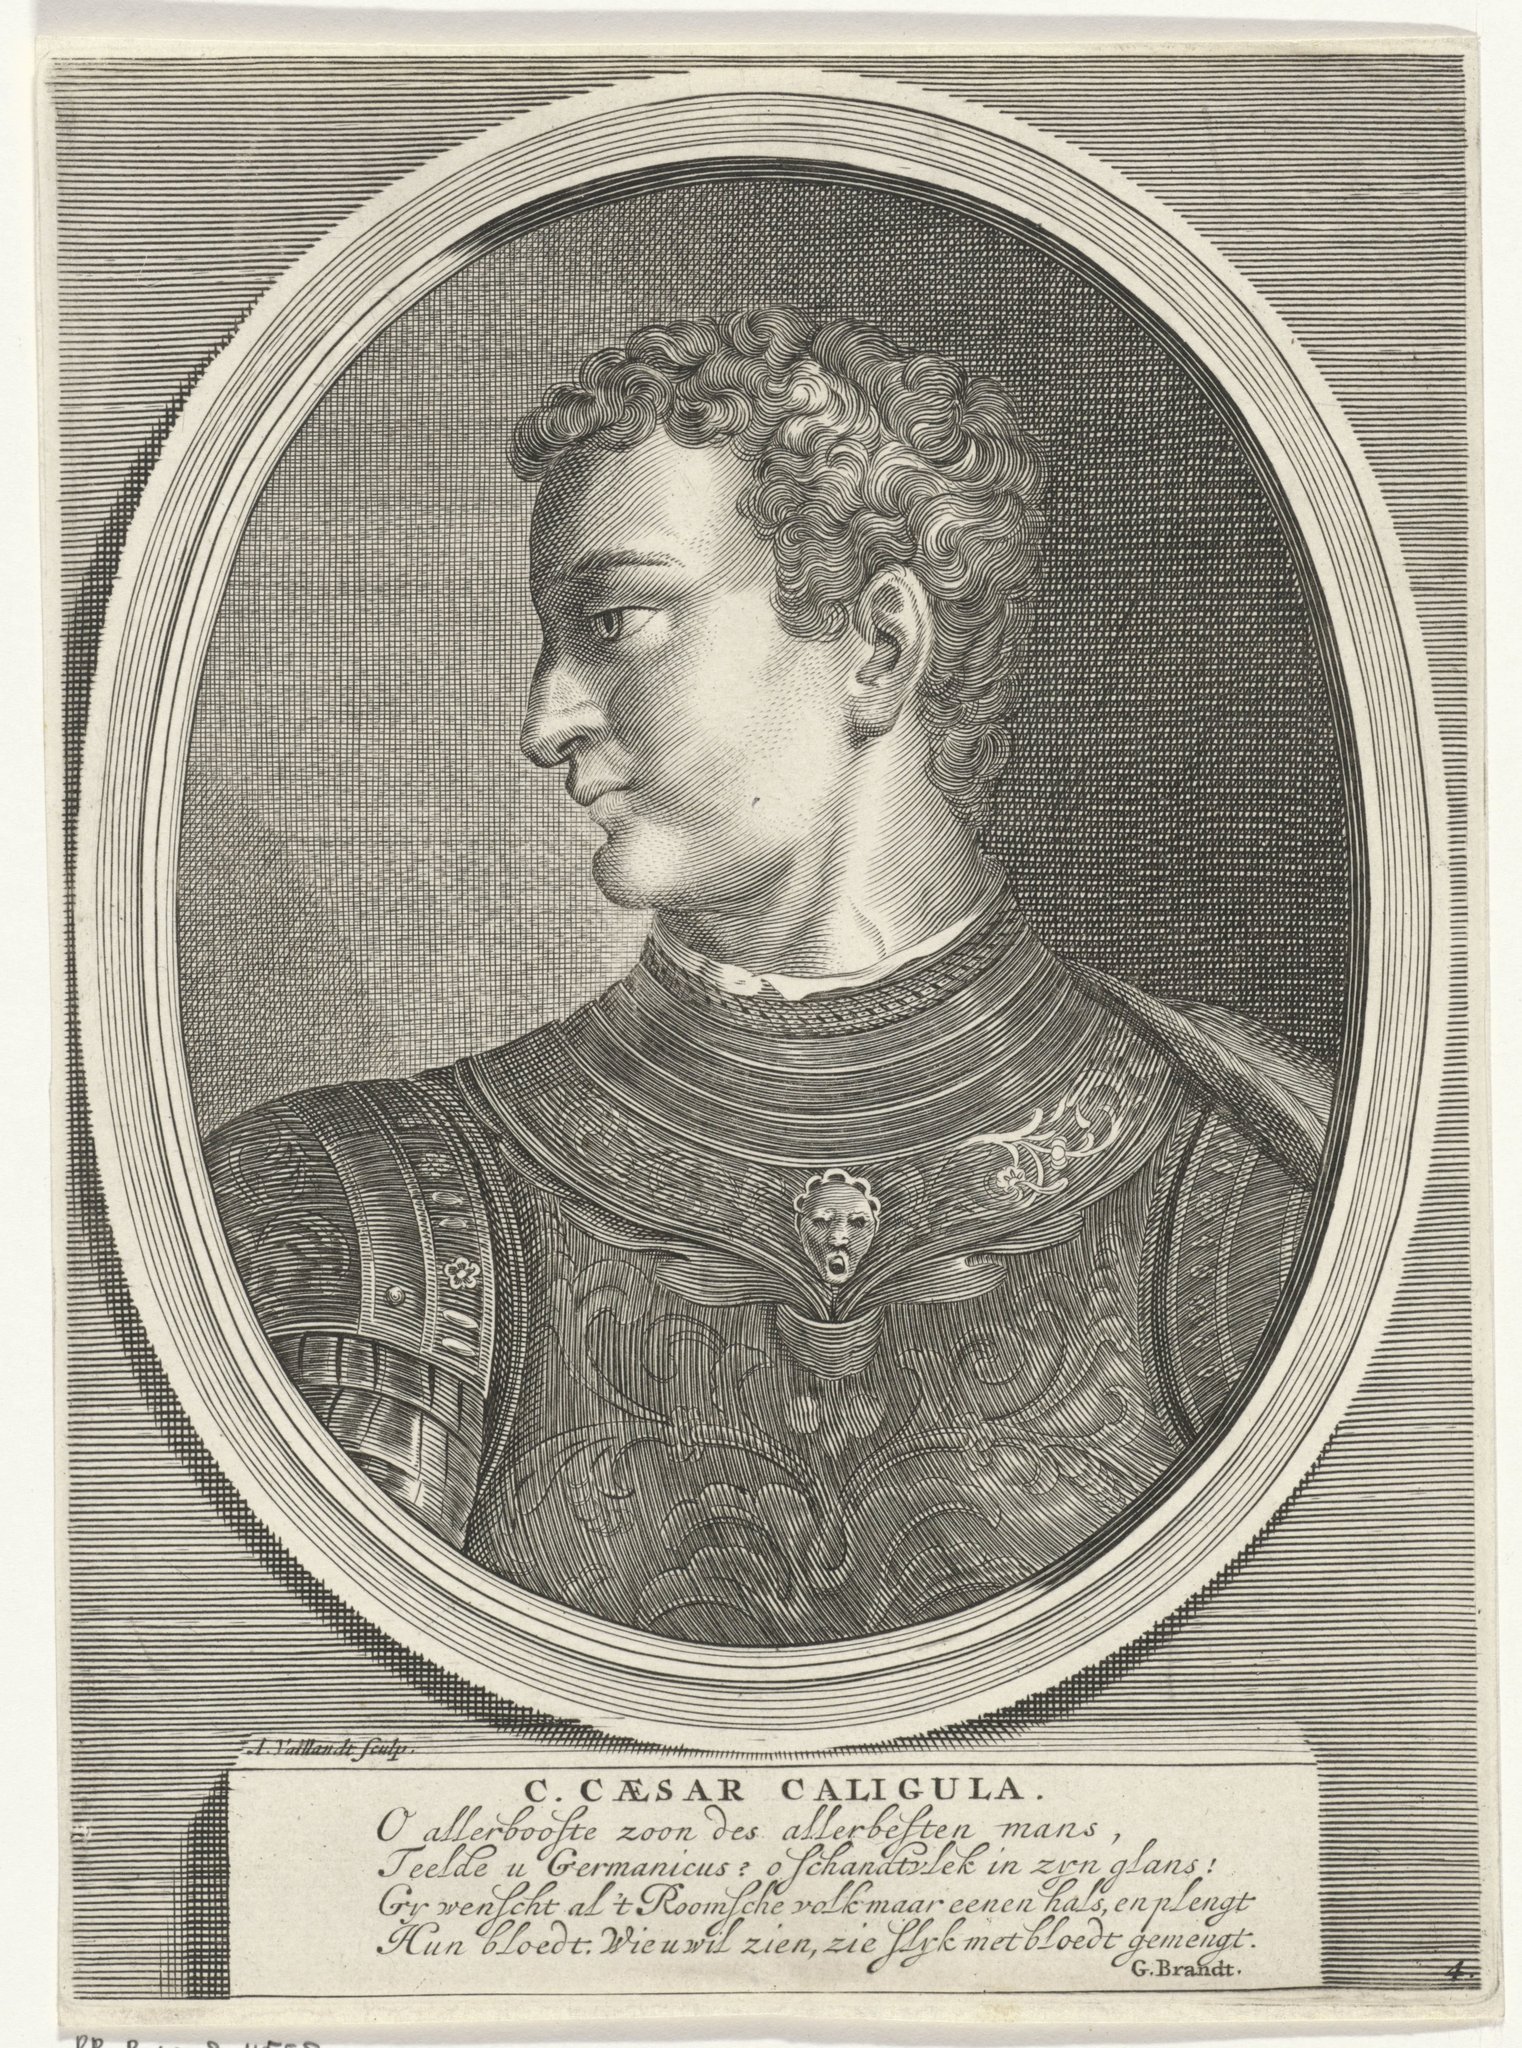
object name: print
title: Romeinse portretten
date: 1665-1693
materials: paper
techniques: engraving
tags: germany, rome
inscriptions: collector's mark: Lugt 2228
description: Portret van Caligula, keizer van het Romeinse Rijk. Prent uit een serie van veertien portretten van Romeinse keizers, Germanicus en Seneca.